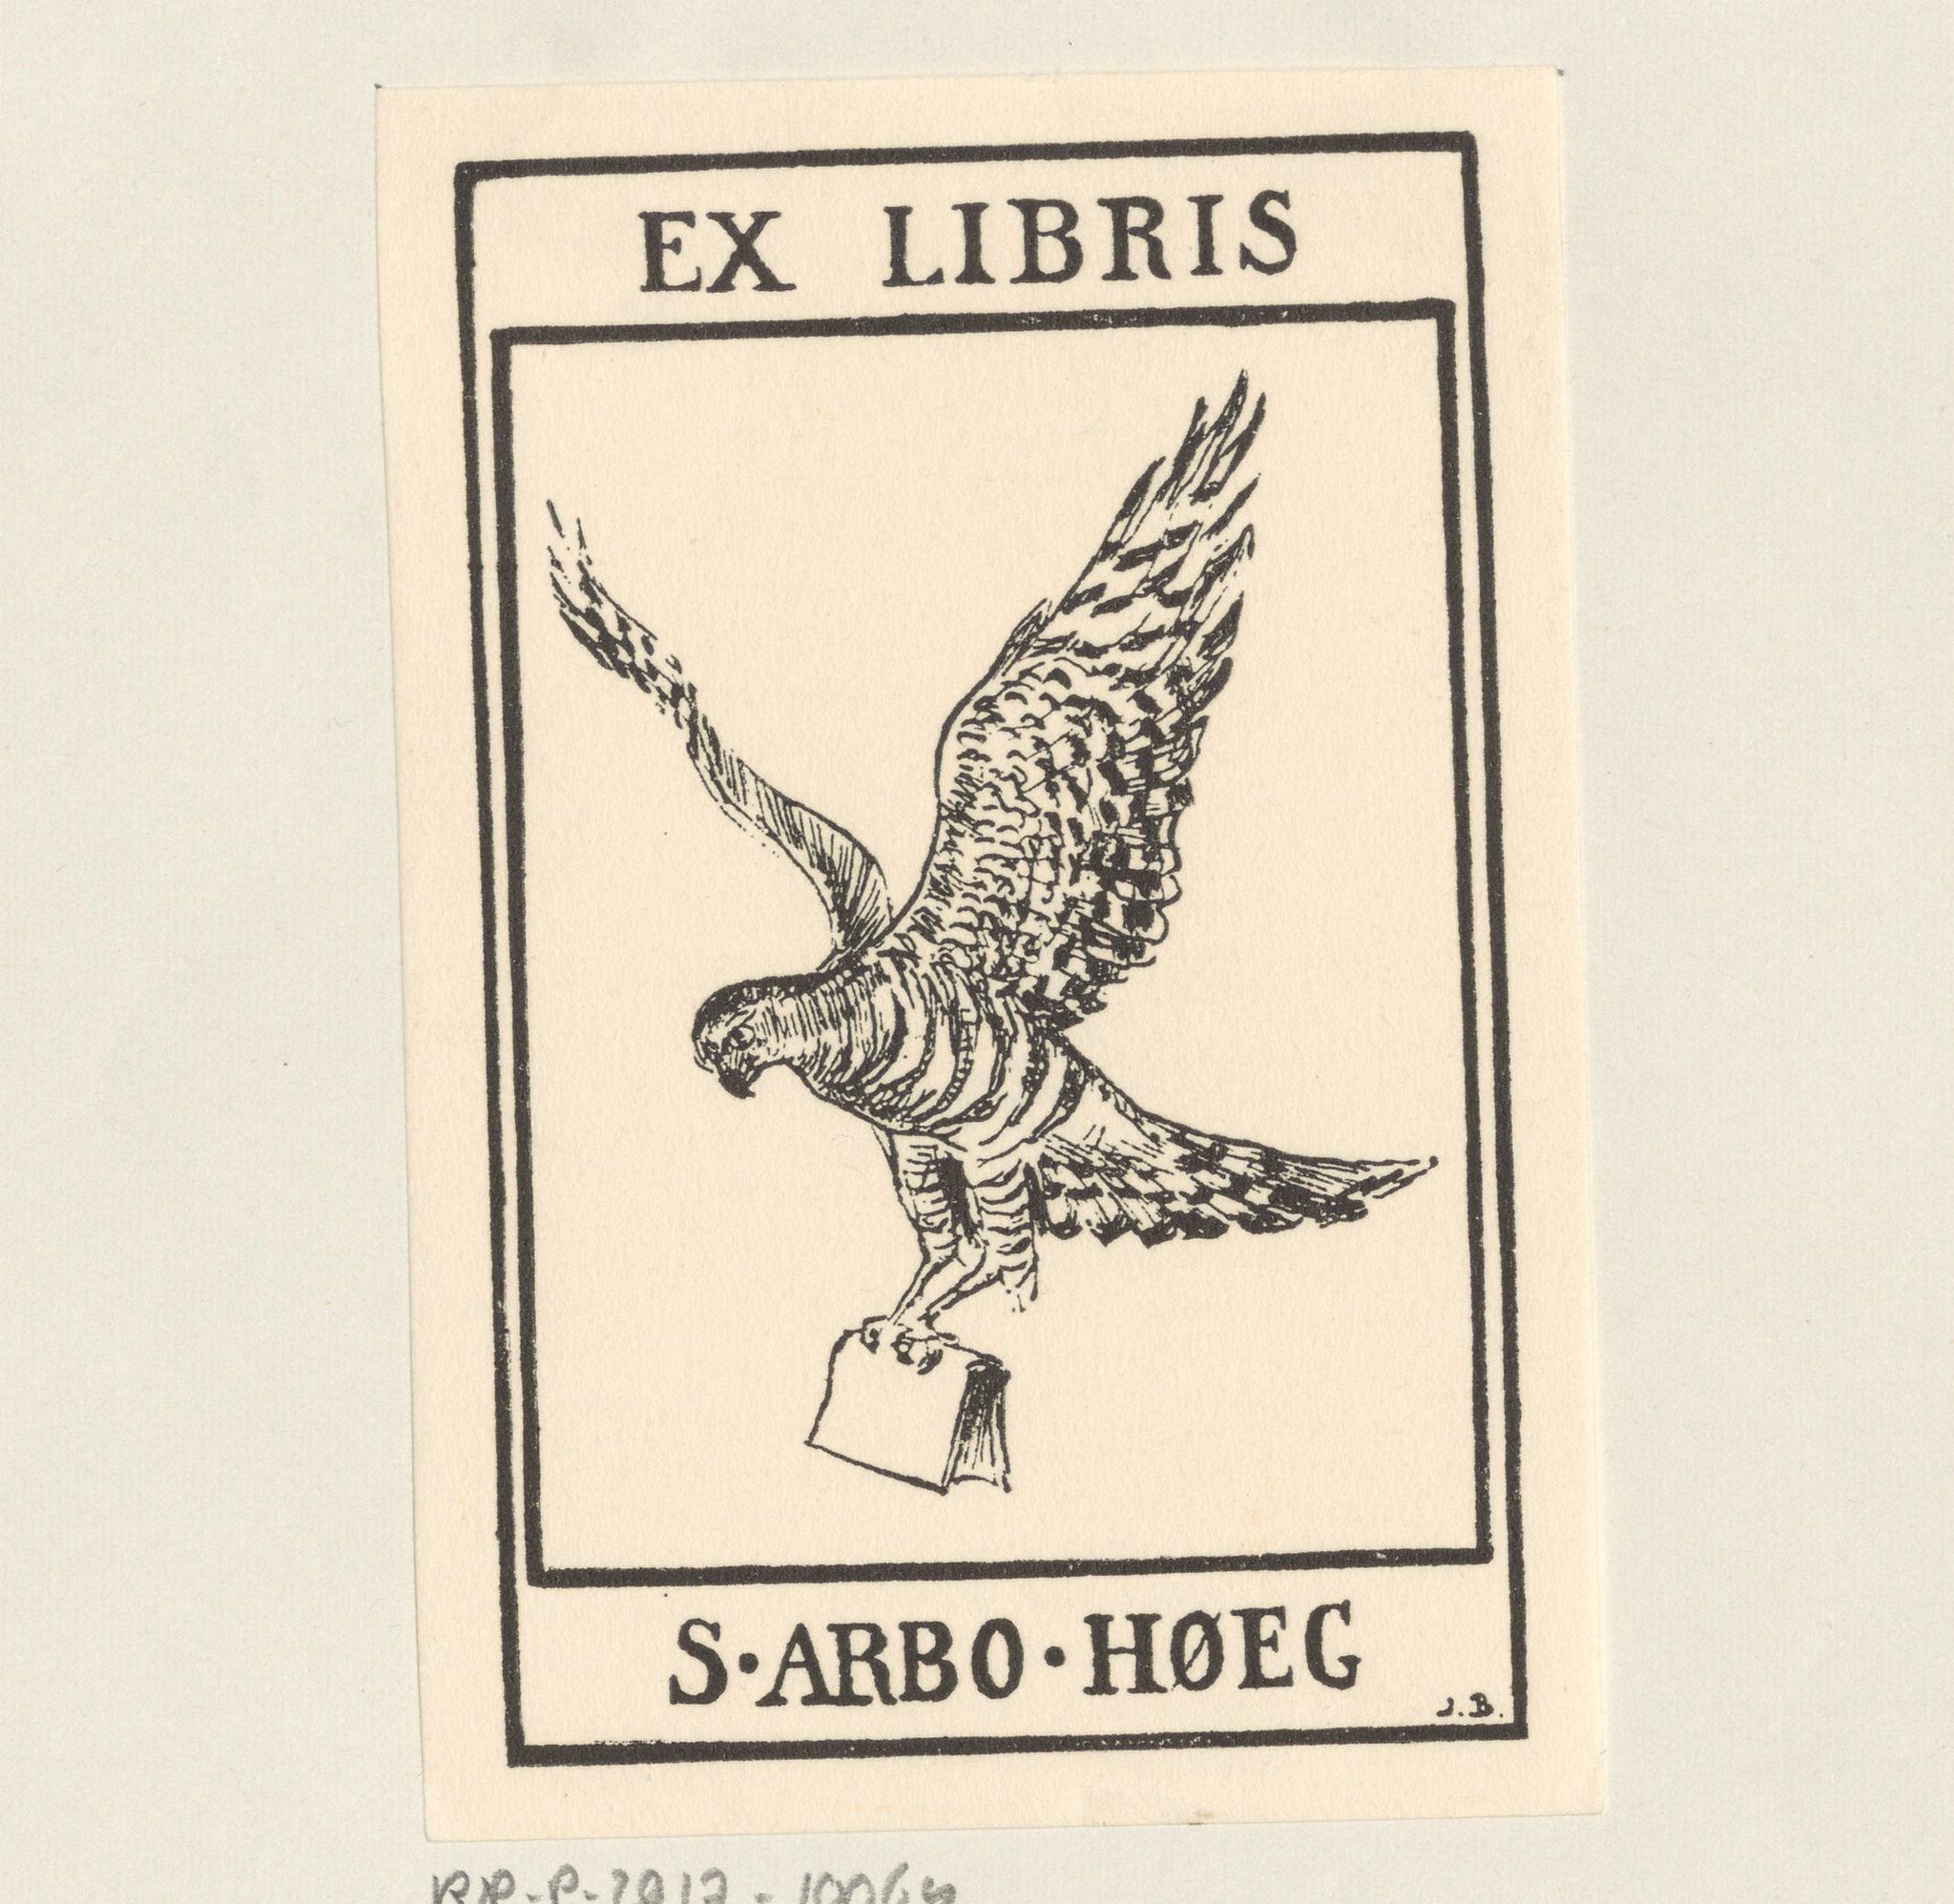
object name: bookplate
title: Ex libris van S. Arbo Høeg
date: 1900-1999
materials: paper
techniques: printing block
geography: denmark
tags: book, predatory birds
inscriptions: inscription: ‘Jens/ Blom’